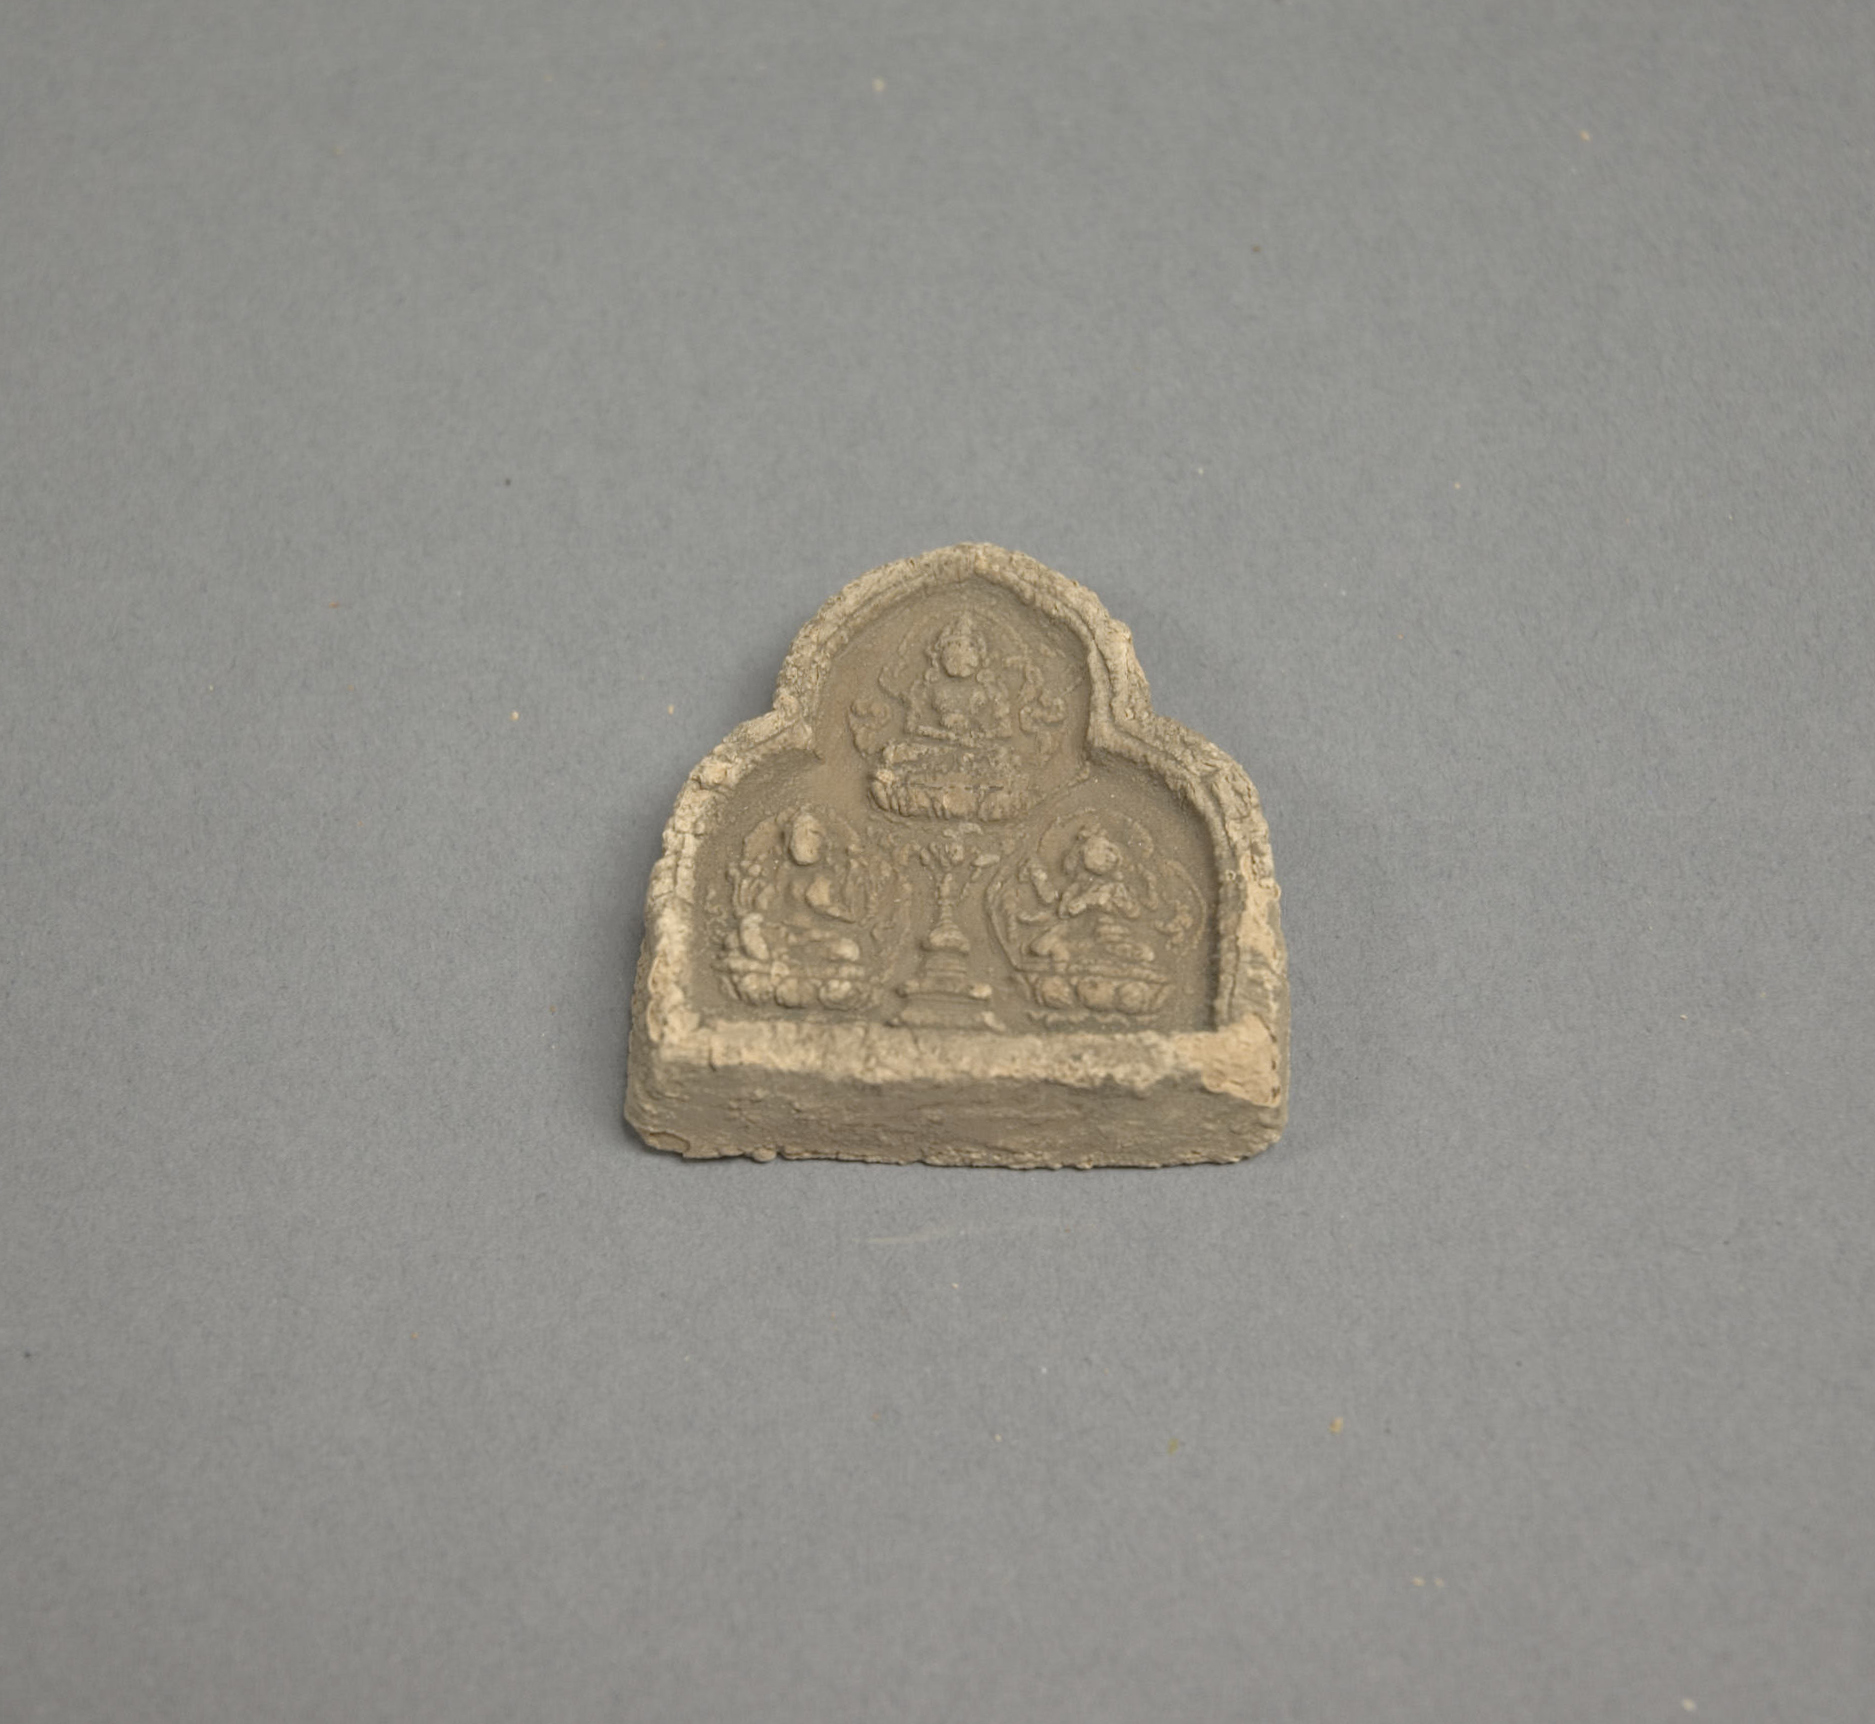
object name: votive tablet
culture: chinese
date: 1368-1644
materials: pottery